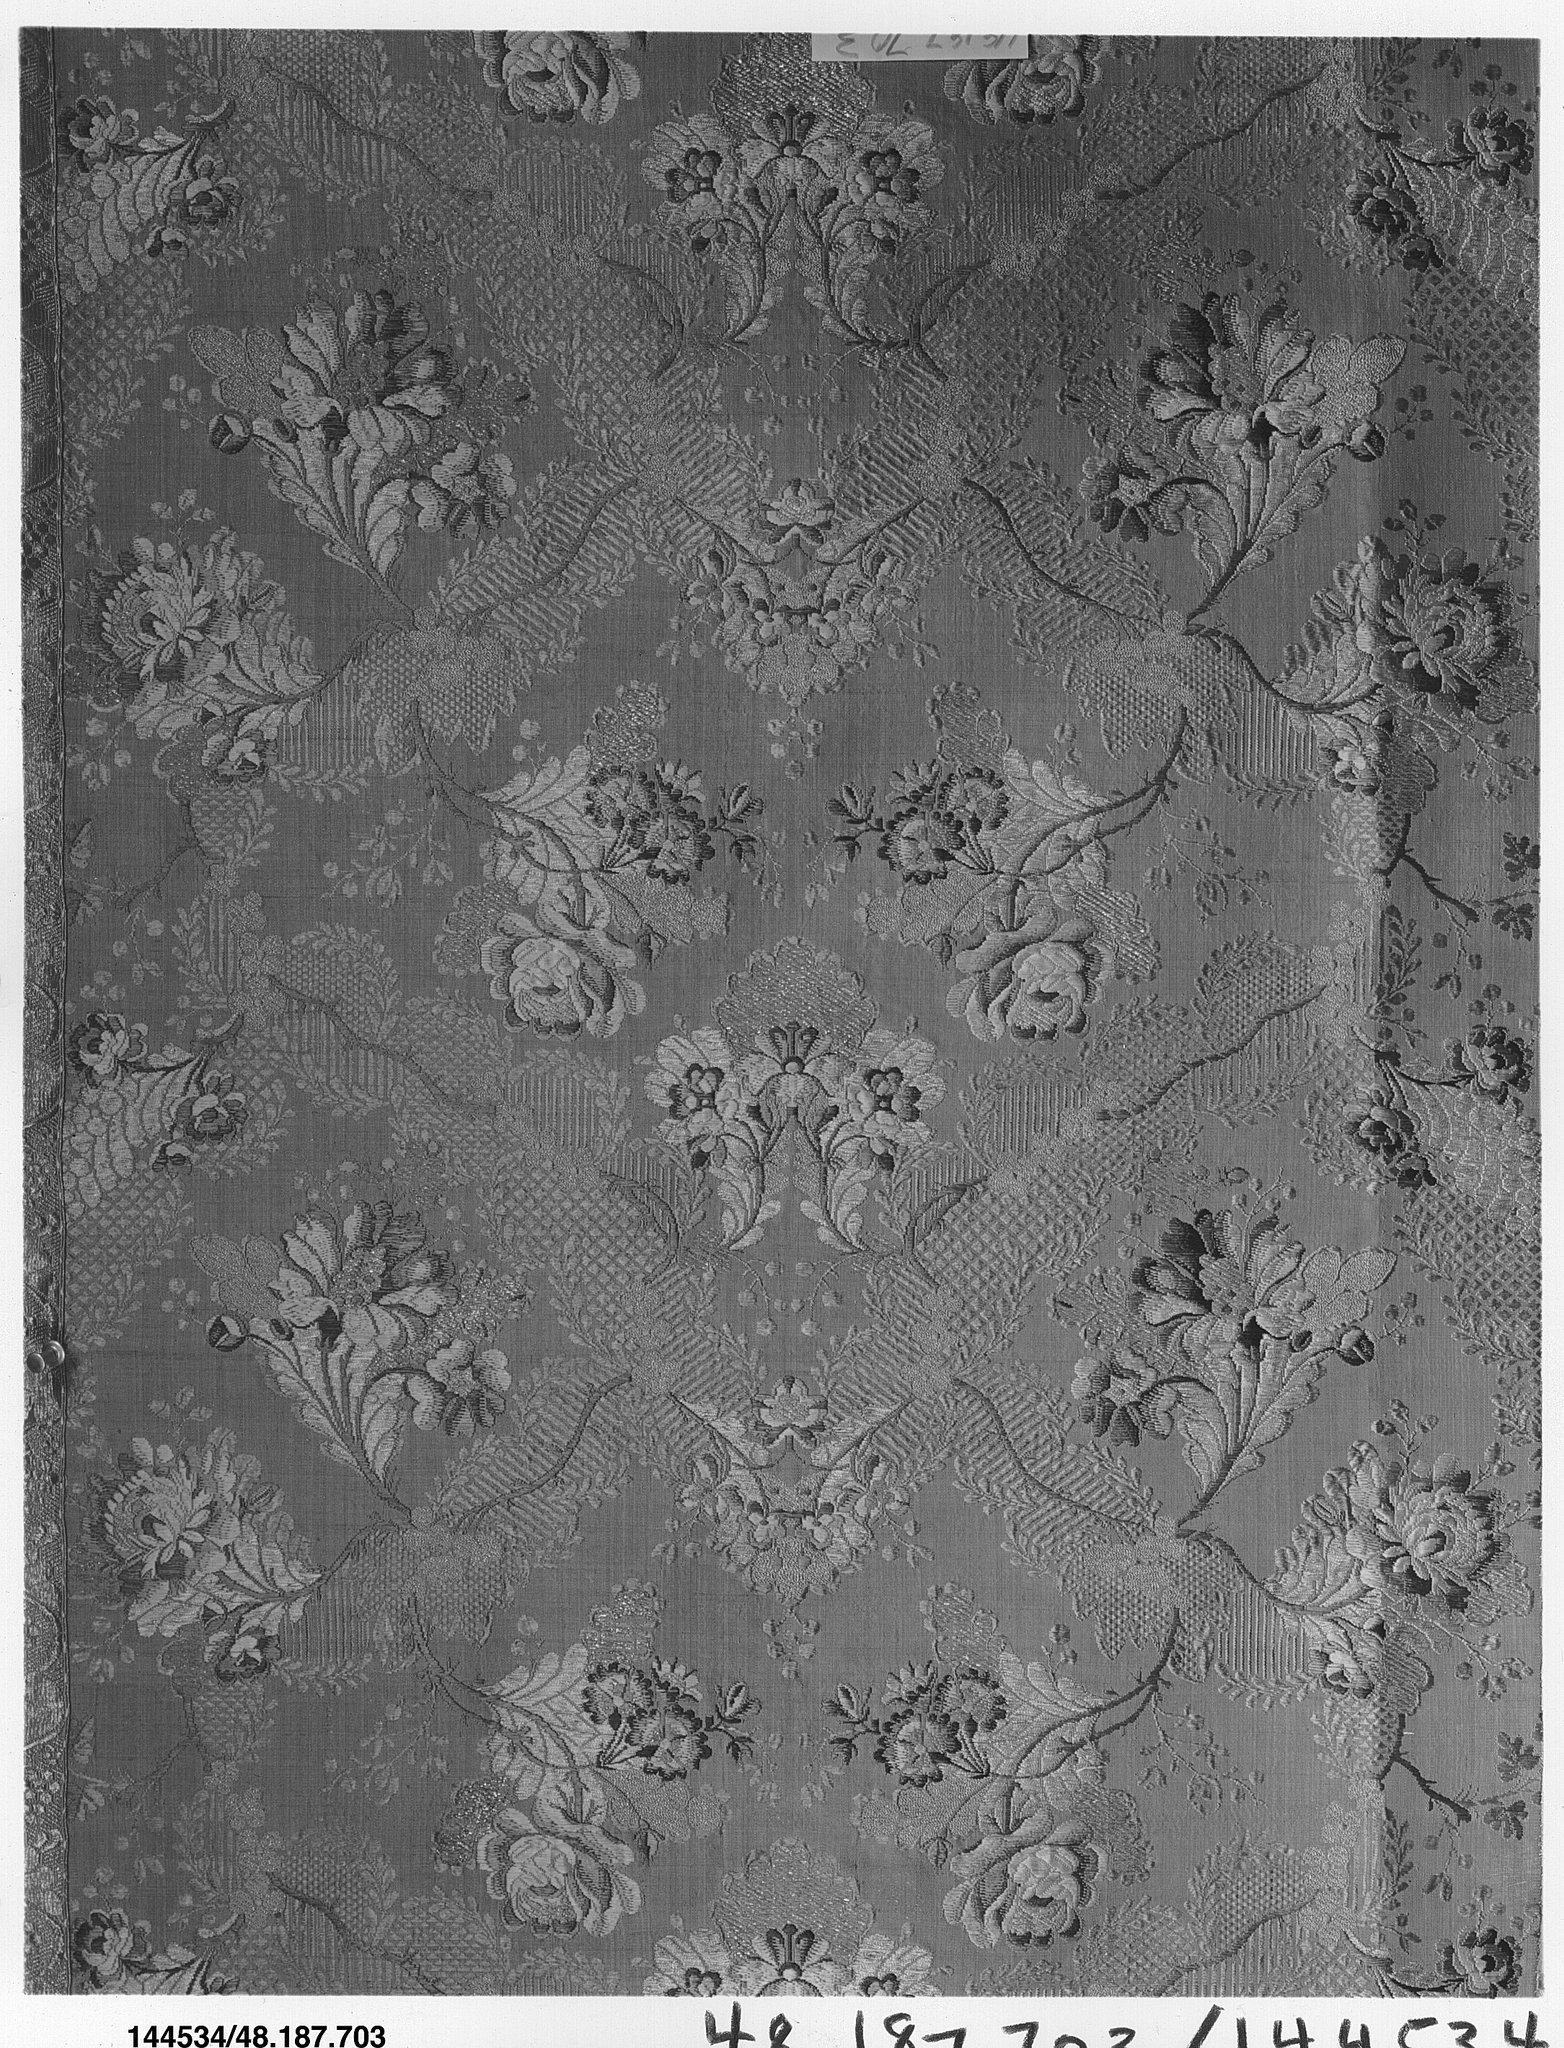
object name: piece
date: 1734-1766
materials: metal thread, silk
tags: flowers